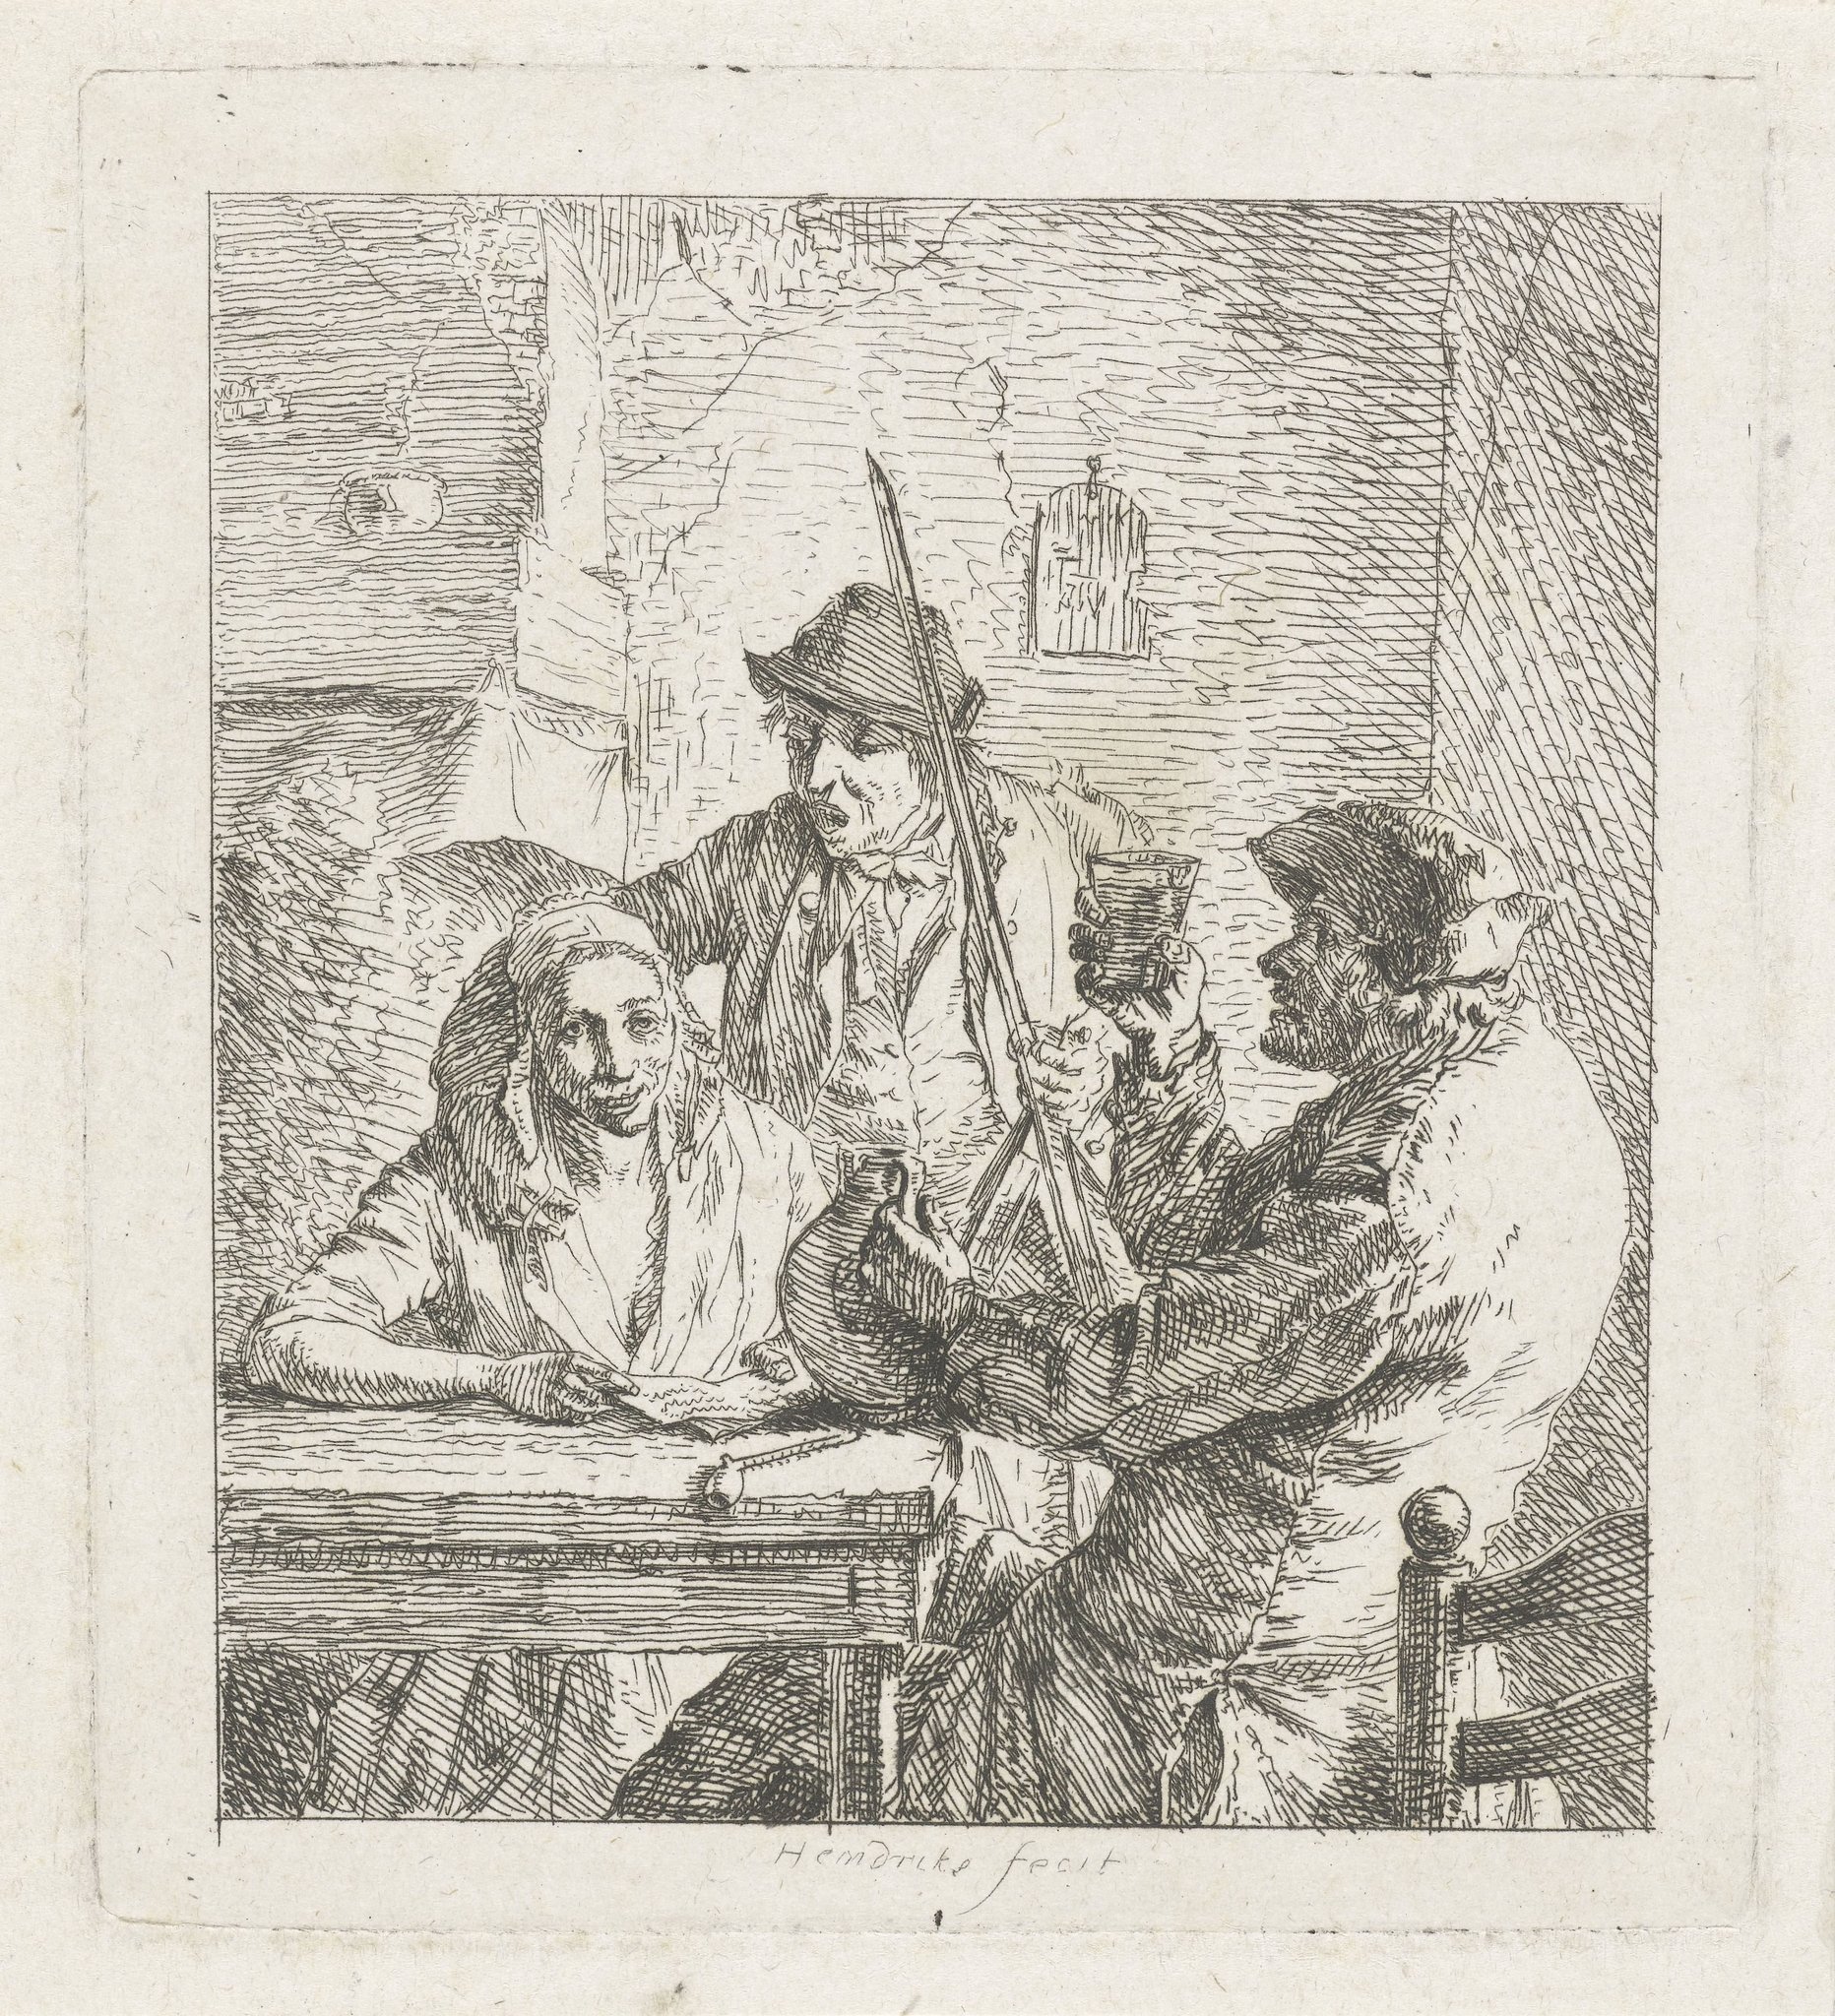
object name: print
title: Drinkende man, vrouw en violist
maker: wybrand hendriks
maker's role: draughtsman, painter, print maker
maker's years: 1744-1831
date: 1759-1831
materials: paper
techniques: etching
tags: violin, fiddle, glass, rummer, one person with musical instrument, not playing, container of ceramics: jar, jug, pot, vase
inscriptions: collector's mark: Lugt 2233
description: Een man met opgeheven glas in de ene en een kruik in de ander hand zit aan een tafel met een lezende vrouw. Om de hals van de vrouw heeft een staande man, met een viool en strijkstok in de hand, zijn arm geslagen.